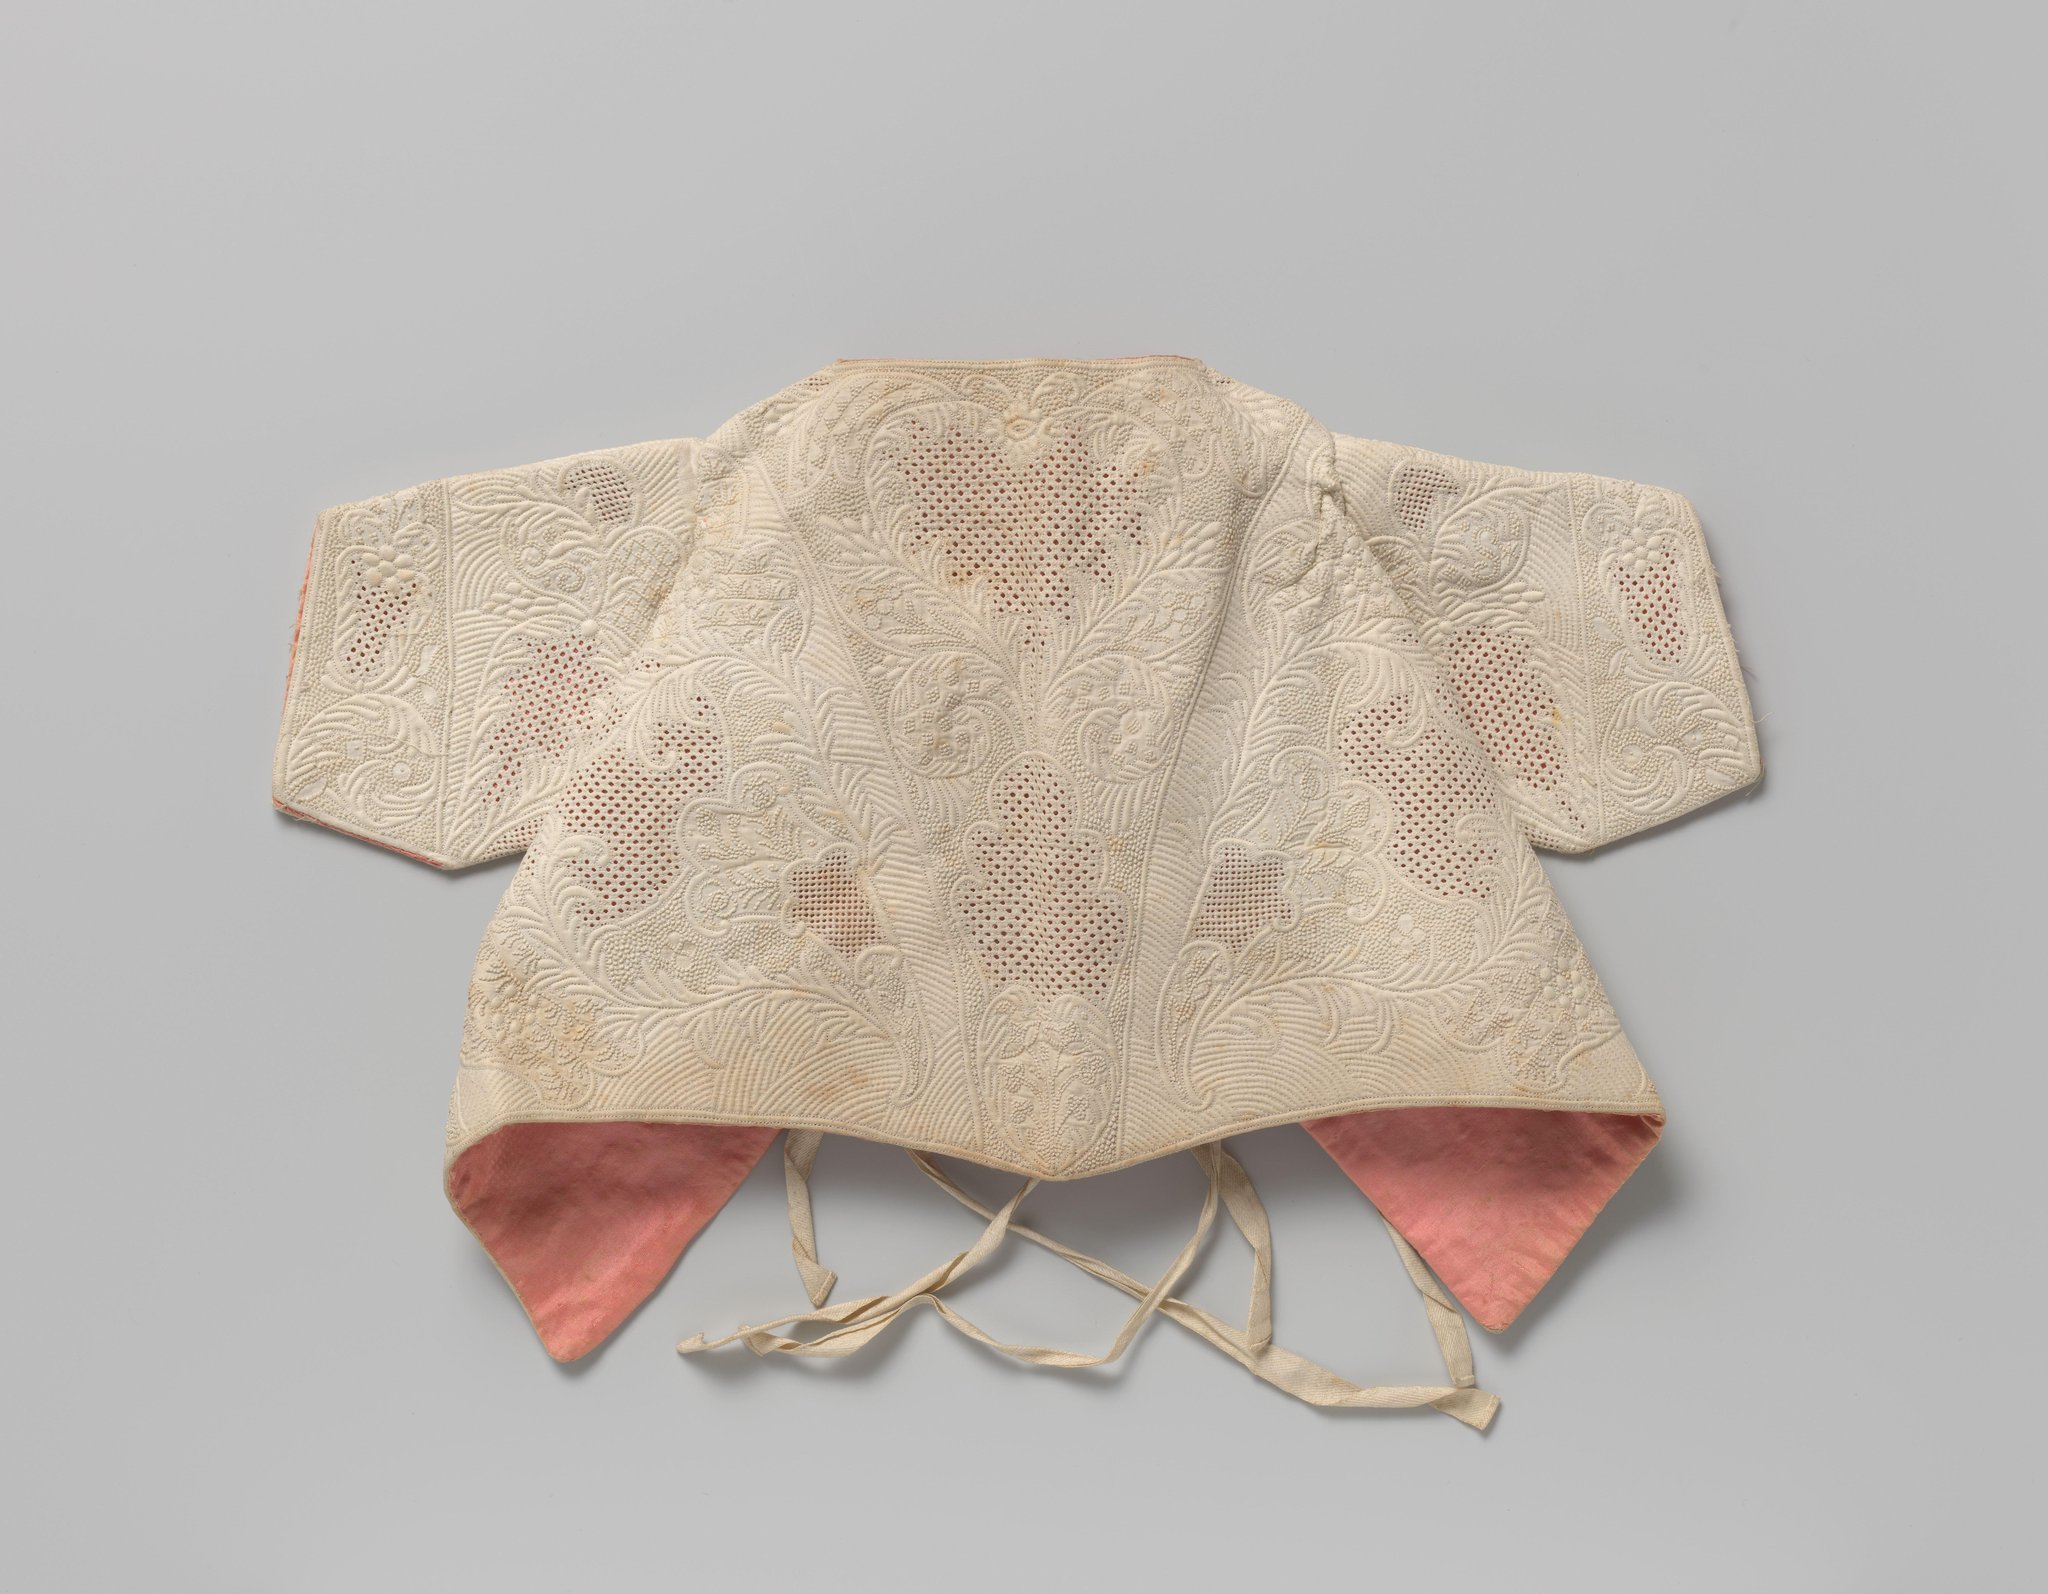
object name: baby wear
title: Babyjak van linnen met Zaans stikwerk, op een opengewerkt fond; voering van roze zijde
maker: Anonymous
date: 1725-1750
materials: linen, silk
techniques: quilted embroidery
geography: netherlands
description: Babyjak van linnen met Zaans stikwerk en open naaiwerk, gevoerd met roze zijde. Het jak heeft een dessin van bladeren, granaatappels en hoornen des overvloeds.